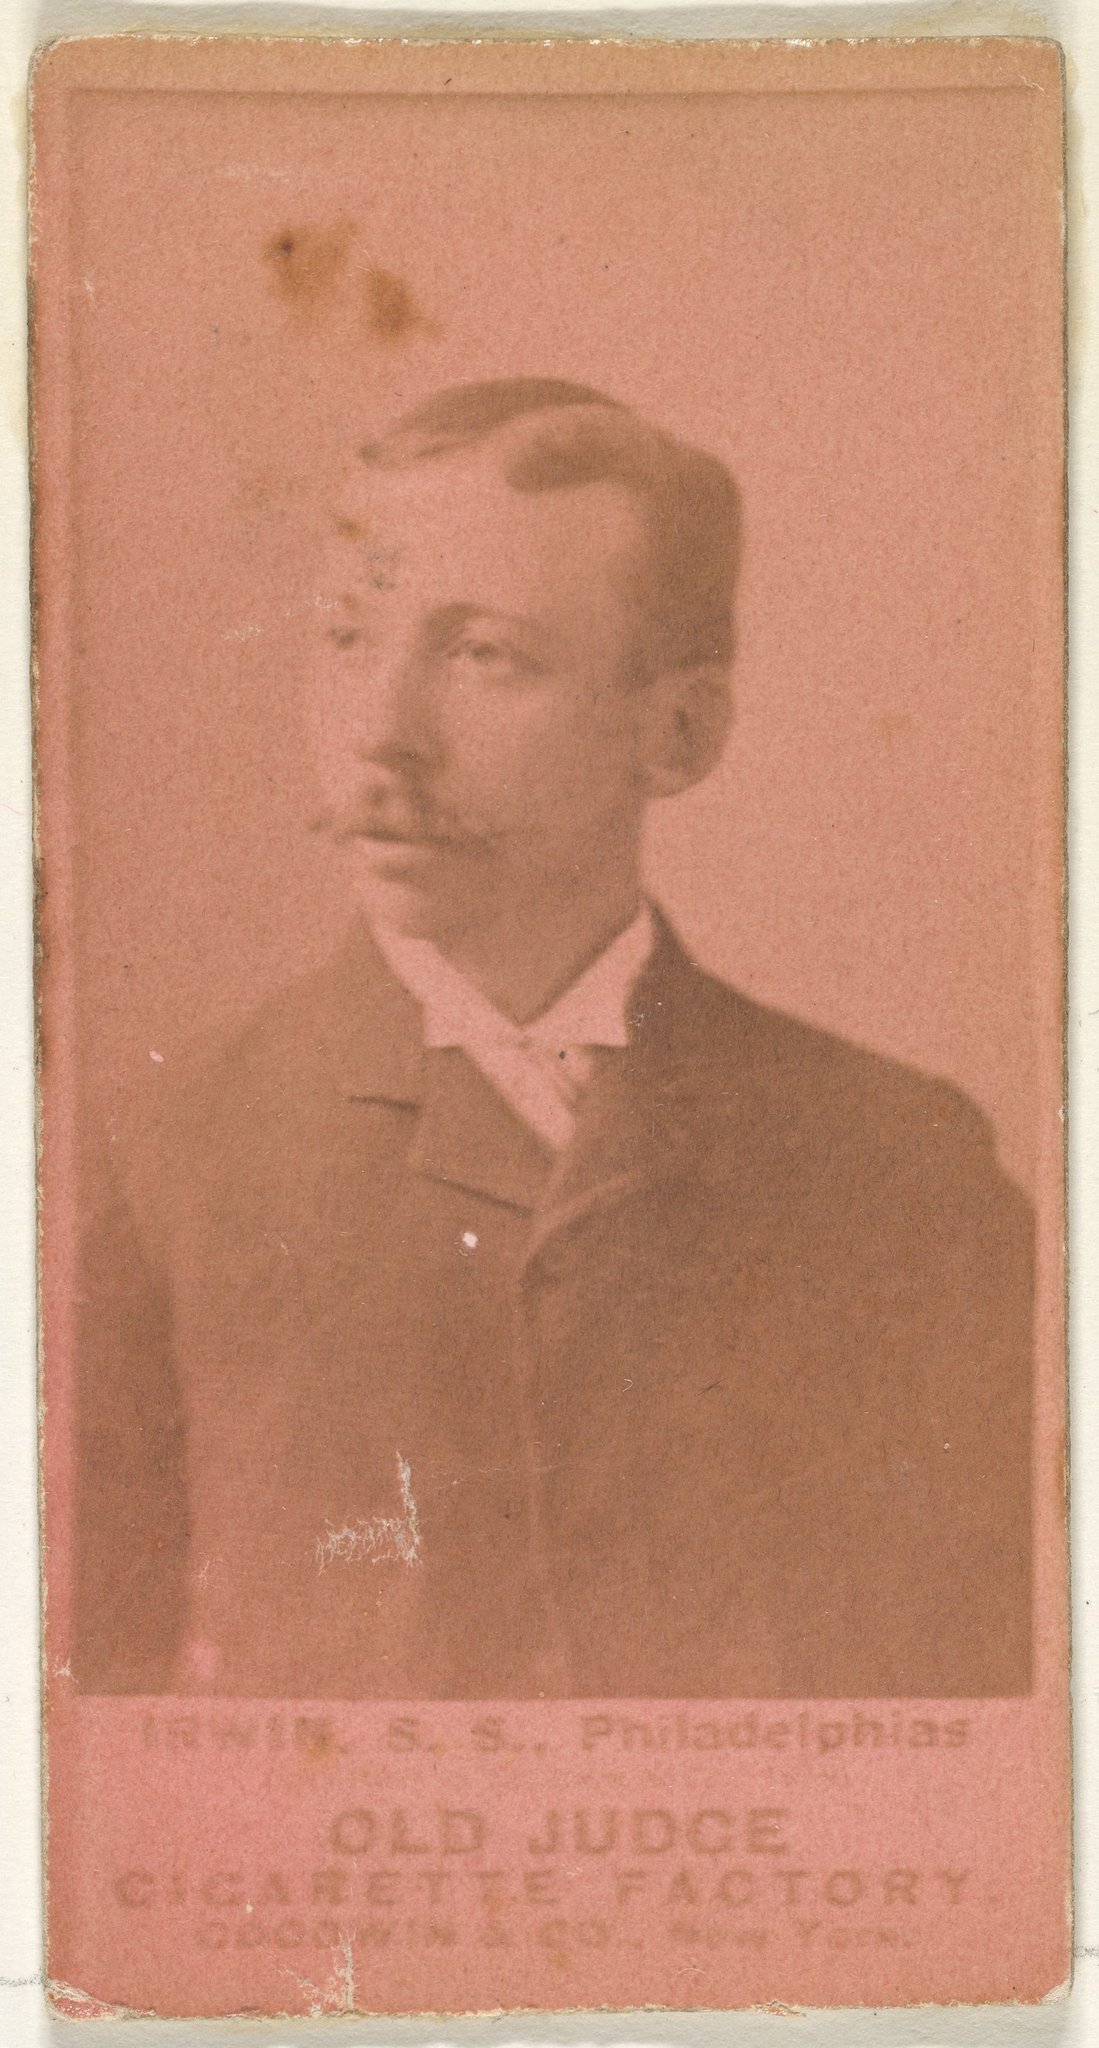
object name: baseball card, photograph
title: Arthur Albert "Doc" Irwin, Shortstop, Philadelphia, from the Old Judge series (N172) for Old Judge Cigarettes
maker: goodwin & company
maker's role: publisher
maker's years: 1850-1950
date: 1887-1890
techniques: albumen silver print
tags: men,portraits,baseball,athletes